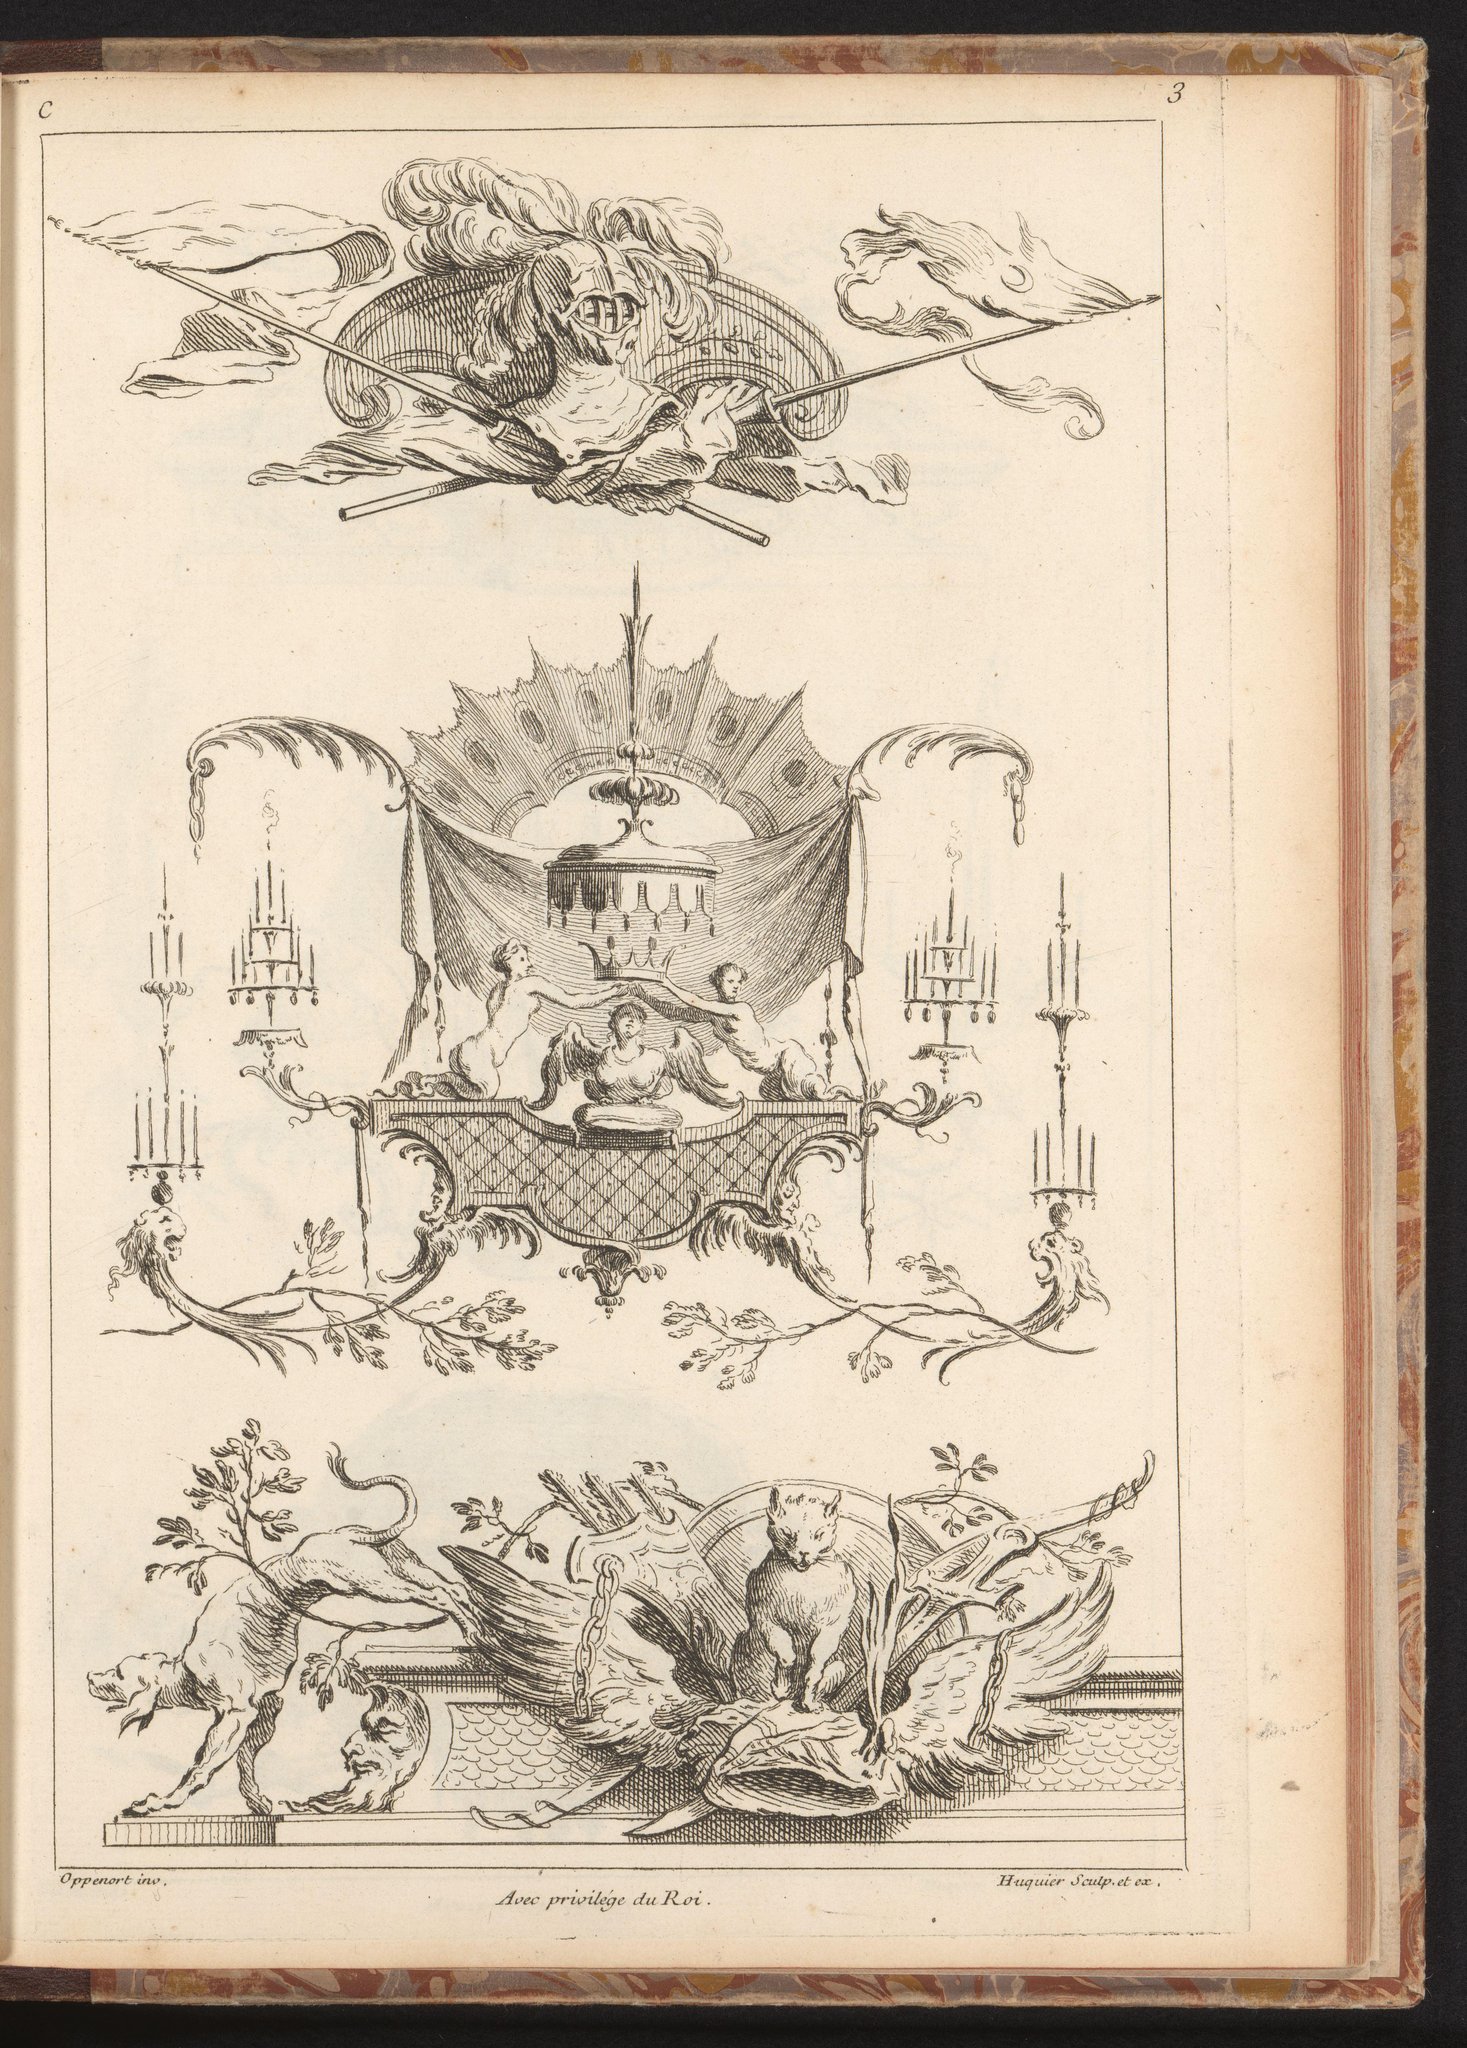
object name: print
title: Troisieme livre contenant des frises ou panneaux en longueur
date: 1740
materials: cardboard, leather, paper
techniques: etching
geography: paris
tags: crown (symbol of sovereignty), ornaments ~ art, archer's weapons: bow and arrow, uniform cap, hacking and thrusting weapons: sword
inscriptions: collector's mark: Lugt 2228a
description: Onderaan een vos met pijl, boog en sabel en een jachthond. Daarboven twee figuren die een derde kronen. Het bovenste ornament bestaat uit een helm voor gekruiste lansen met vaandels. Deze prent maakt deel uit van een album.